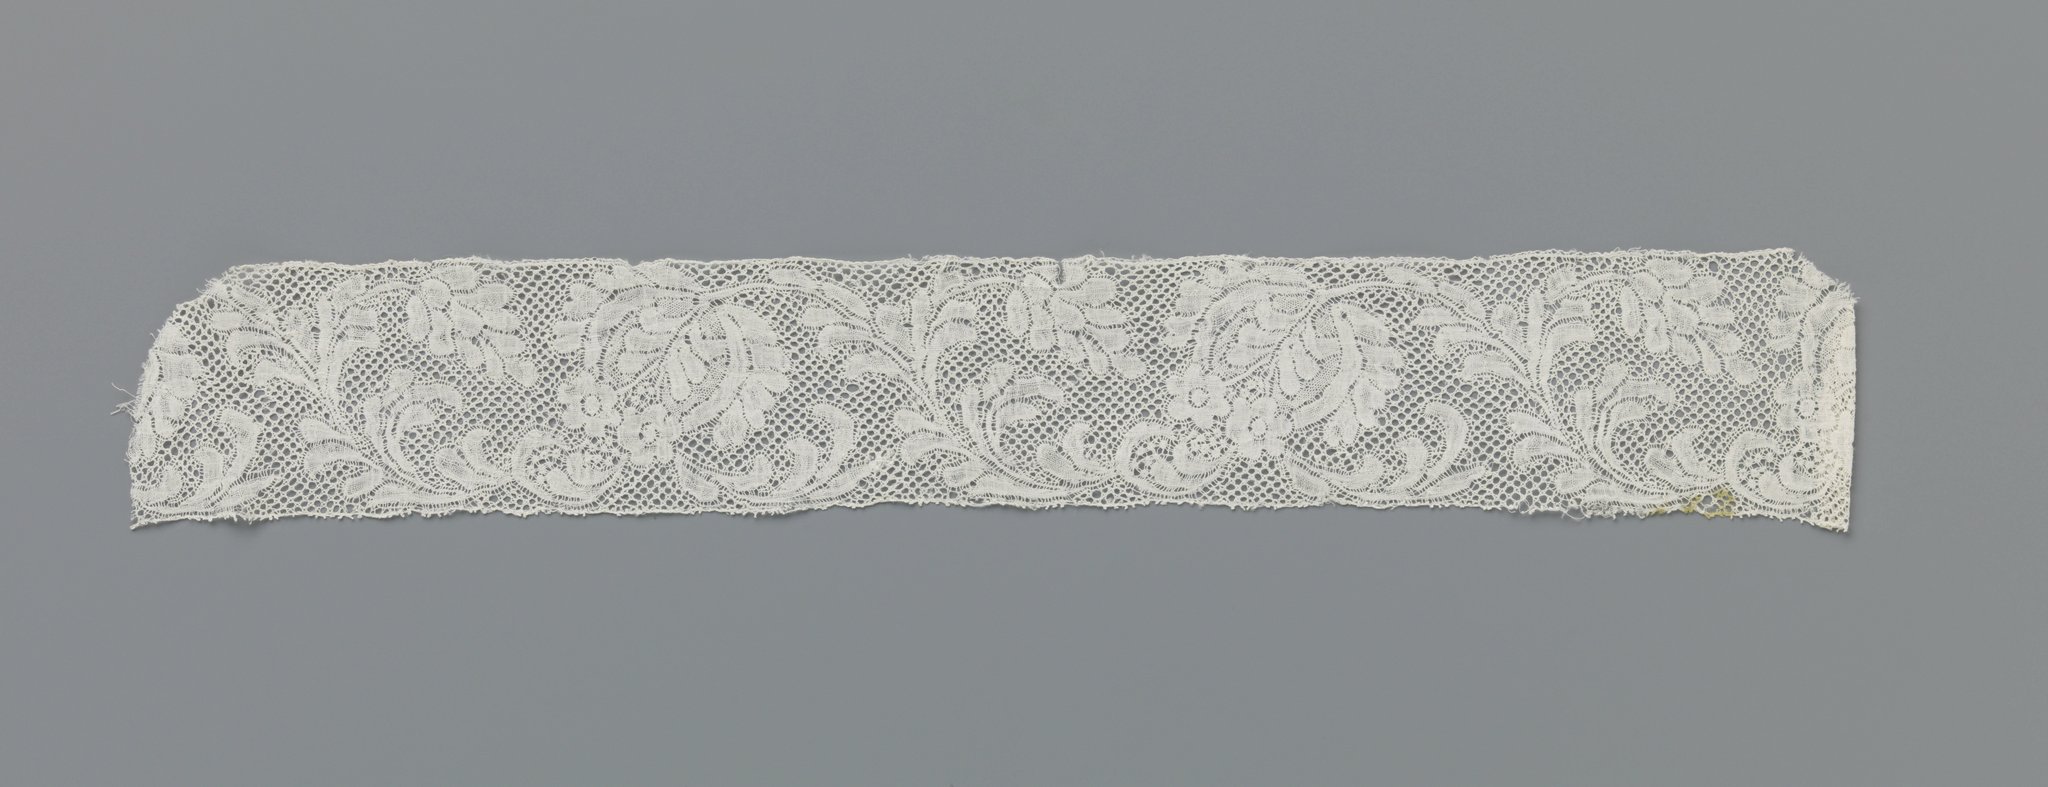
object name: strip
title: Strook kloskant met gespleten tak en tulp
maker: Anonymous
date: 1750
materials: linen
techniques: lace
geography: southern netherlands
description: Strook naturelkleurige kloskant, Binche-kant. Op een traliegrond, een vijfgaatjesgrond, staat een met gevederde bladeren bezette spiraaltak. Een grote tulp, waarin een gespleten tak met twee bloempjes en een kleine druiventros wisselen elkaar af. De motieven zijn gemaakt in linnenslag en netslag met opengewerkte randjes. Als siergrond is spaarzaam een sneeuwvlokkengrond toegepast. Boven- en onderzijde van de strook zijn recht afgewerkt, waarbij de onderzijde is voorzien van picots.